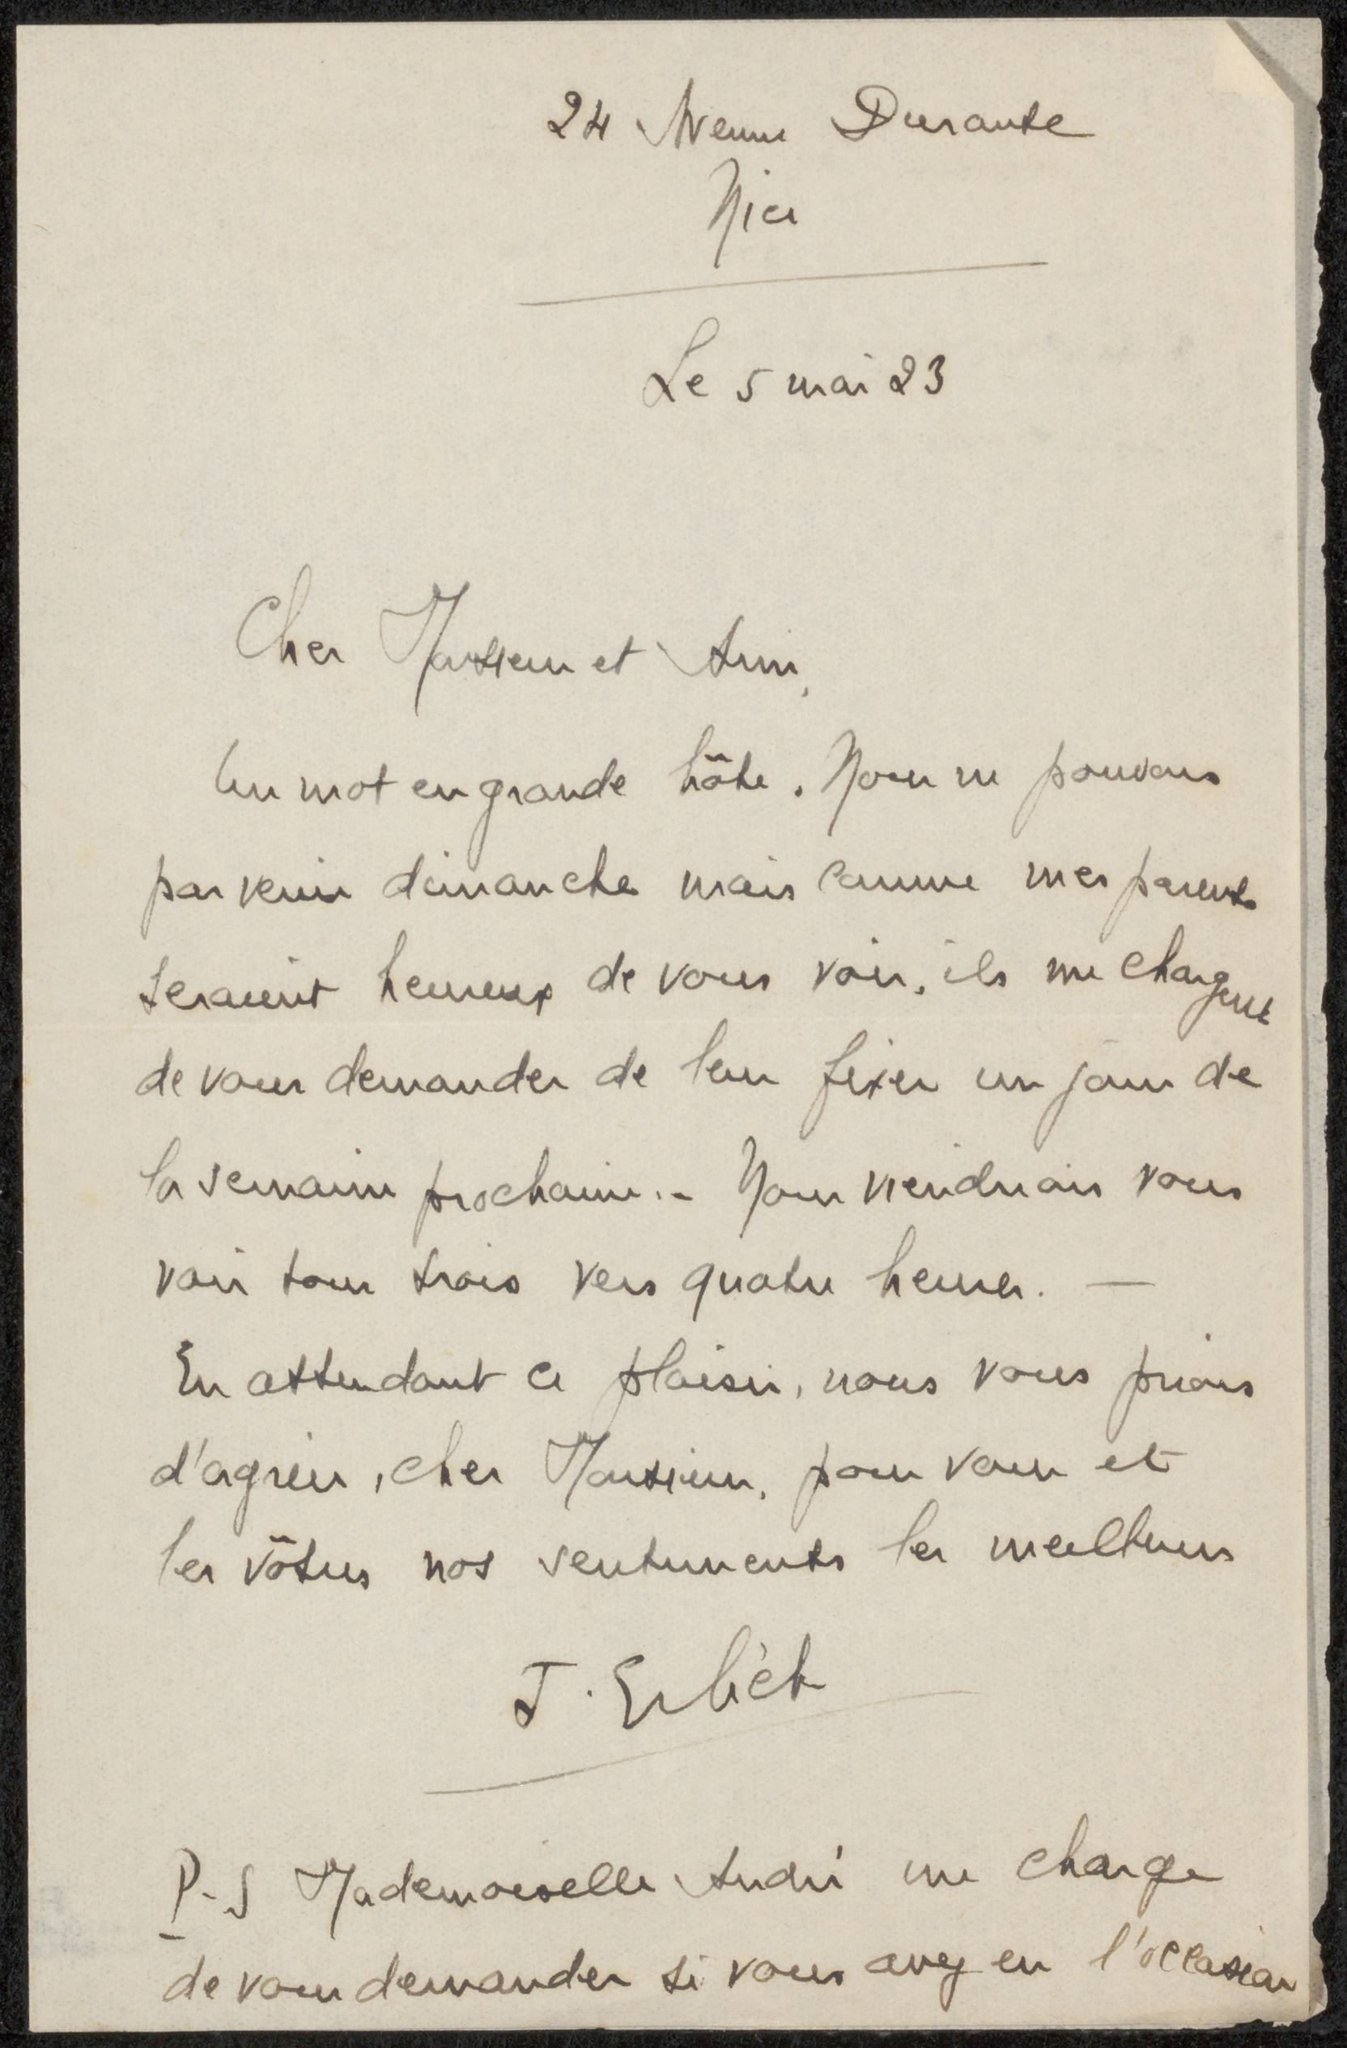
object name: letter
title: Brief aan Philip Zilcken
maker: jeanne erlich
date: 1923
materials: ink, paper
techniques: pen, writing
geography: nice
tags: the hague, painter, draughtsman, philip zilcken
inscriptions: collector's mark: ‘RPK’